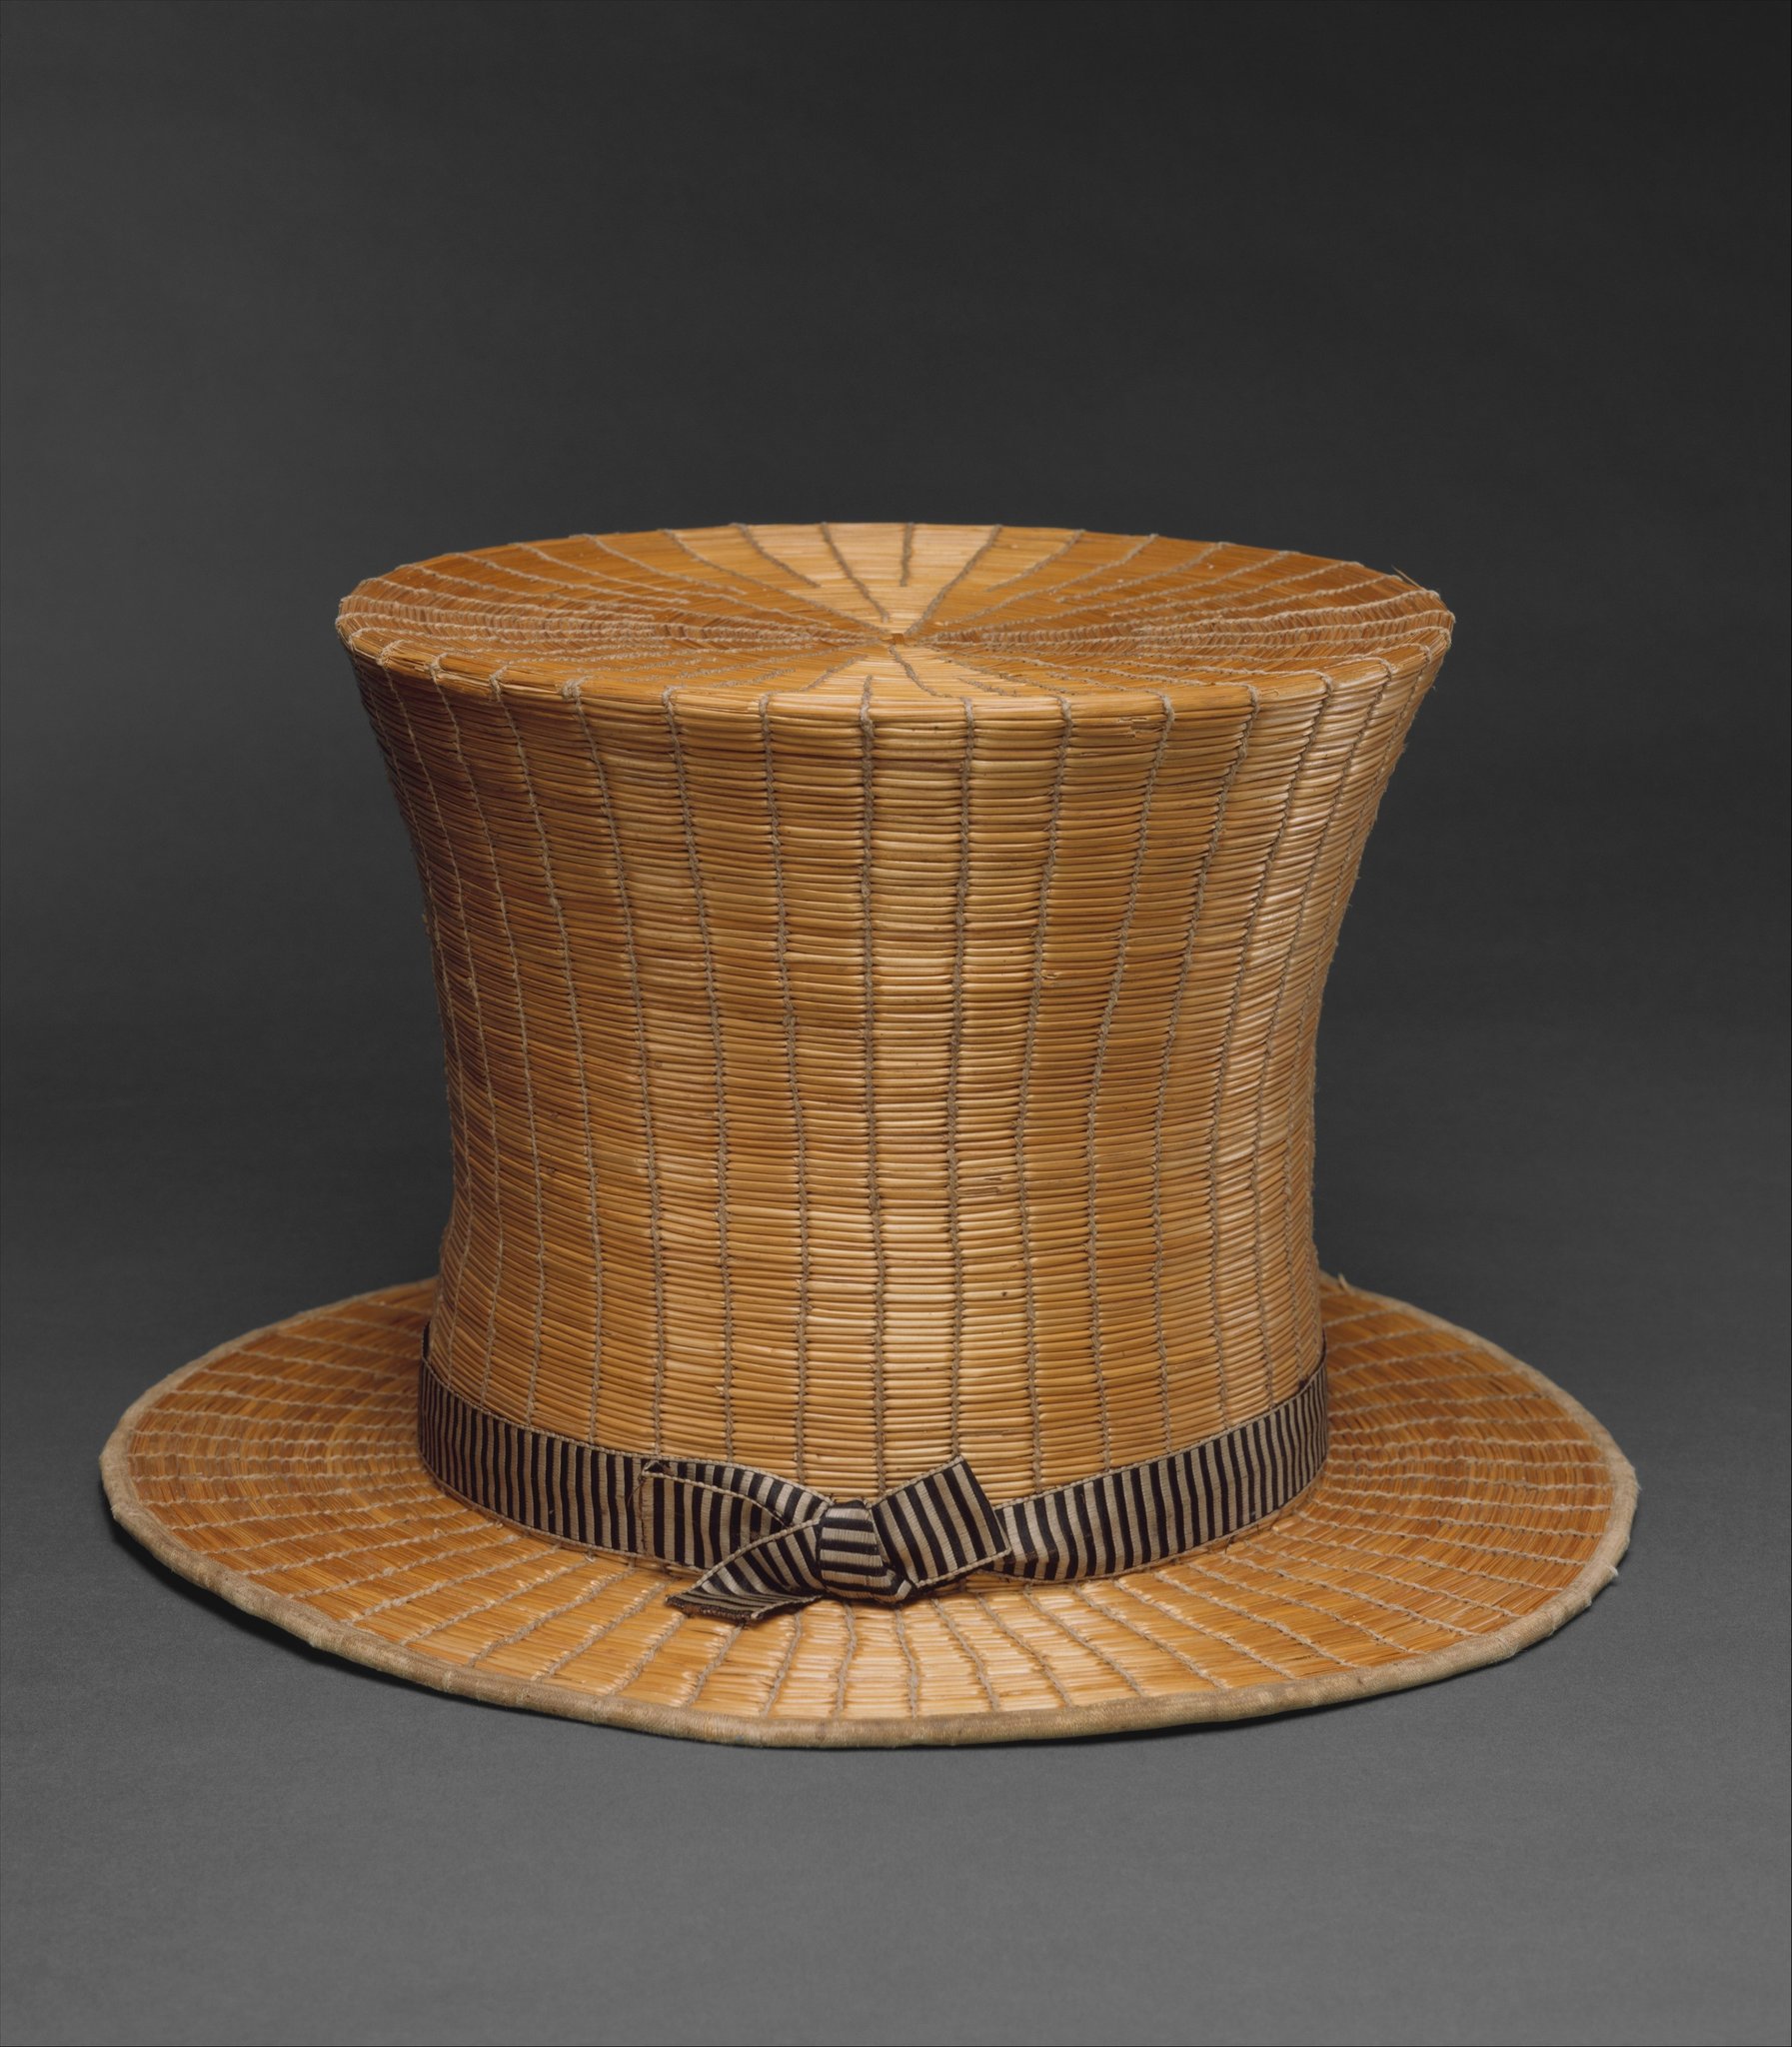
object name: top hat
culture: french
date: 1820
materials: raffia, silk